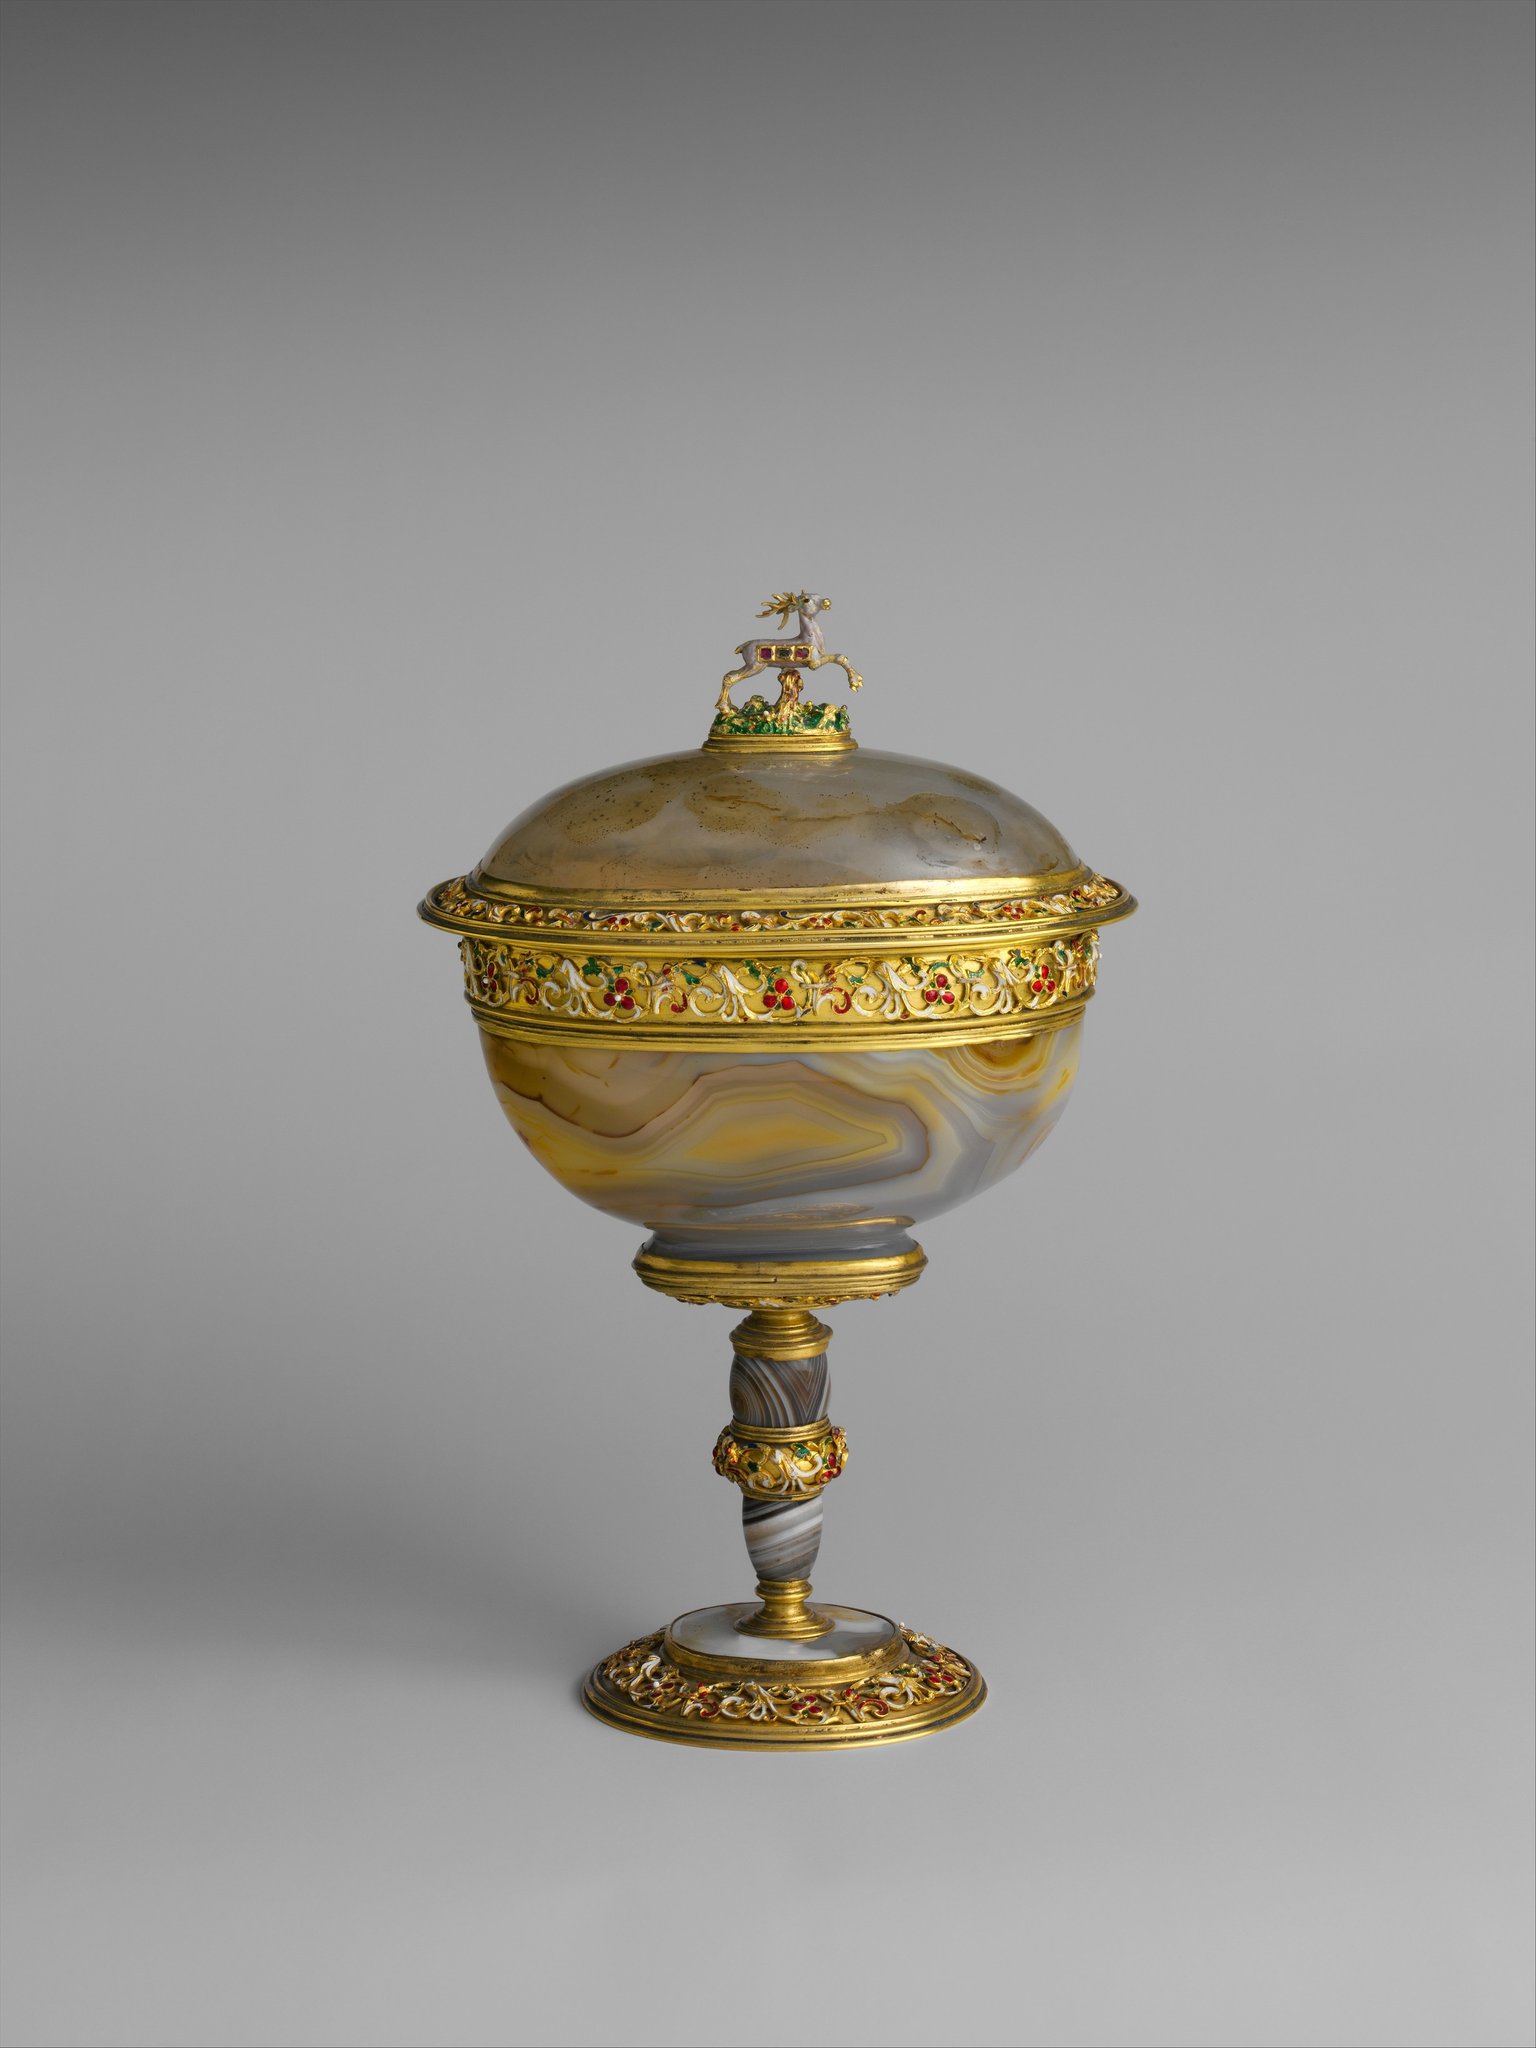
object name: cup with cover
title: Standing cup with cover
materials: stone, diamond, enamel, gold, gemstone, silver gilt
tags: deer,flowers